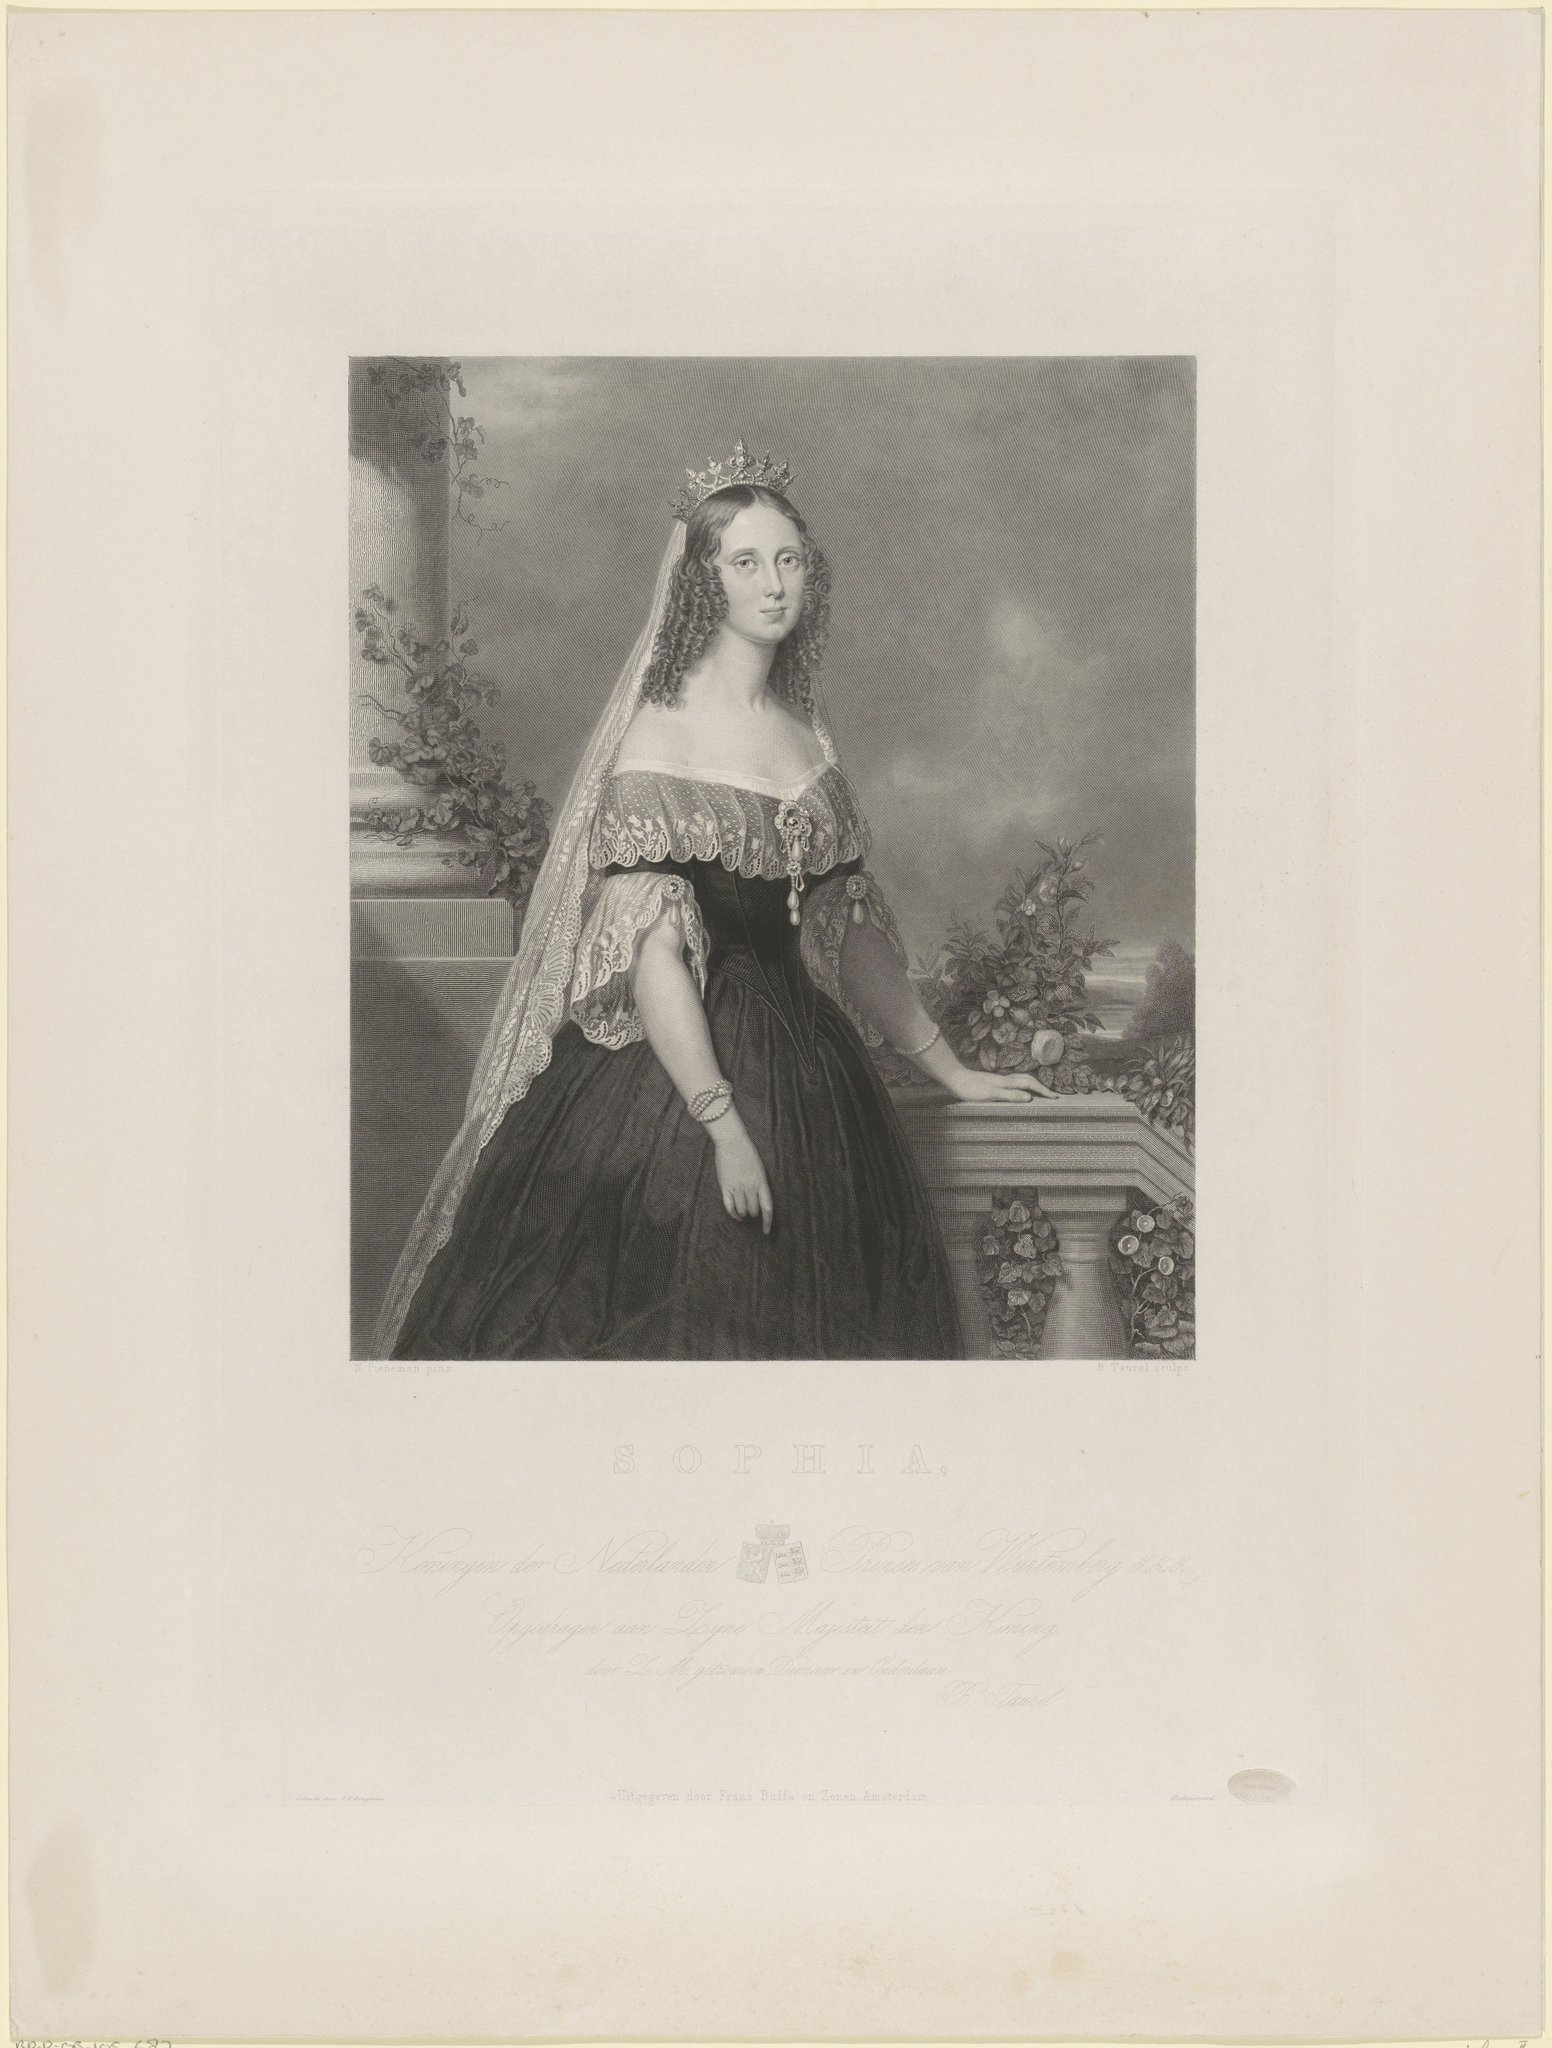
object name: print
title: Portret van Sophie van Württemberg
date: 1849-1859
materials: paper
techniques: engraving, etching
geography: amsterdam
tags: the hague, sophia frederika mathilda van württemberg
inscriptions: check stamp: ‘Frans Buffa & Zonen’, collector's mark: Lugt 12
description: Portret van Sophie met een kroon. Midden onder twee wapens met een kroon. In de ondermarge haar naam en titels.